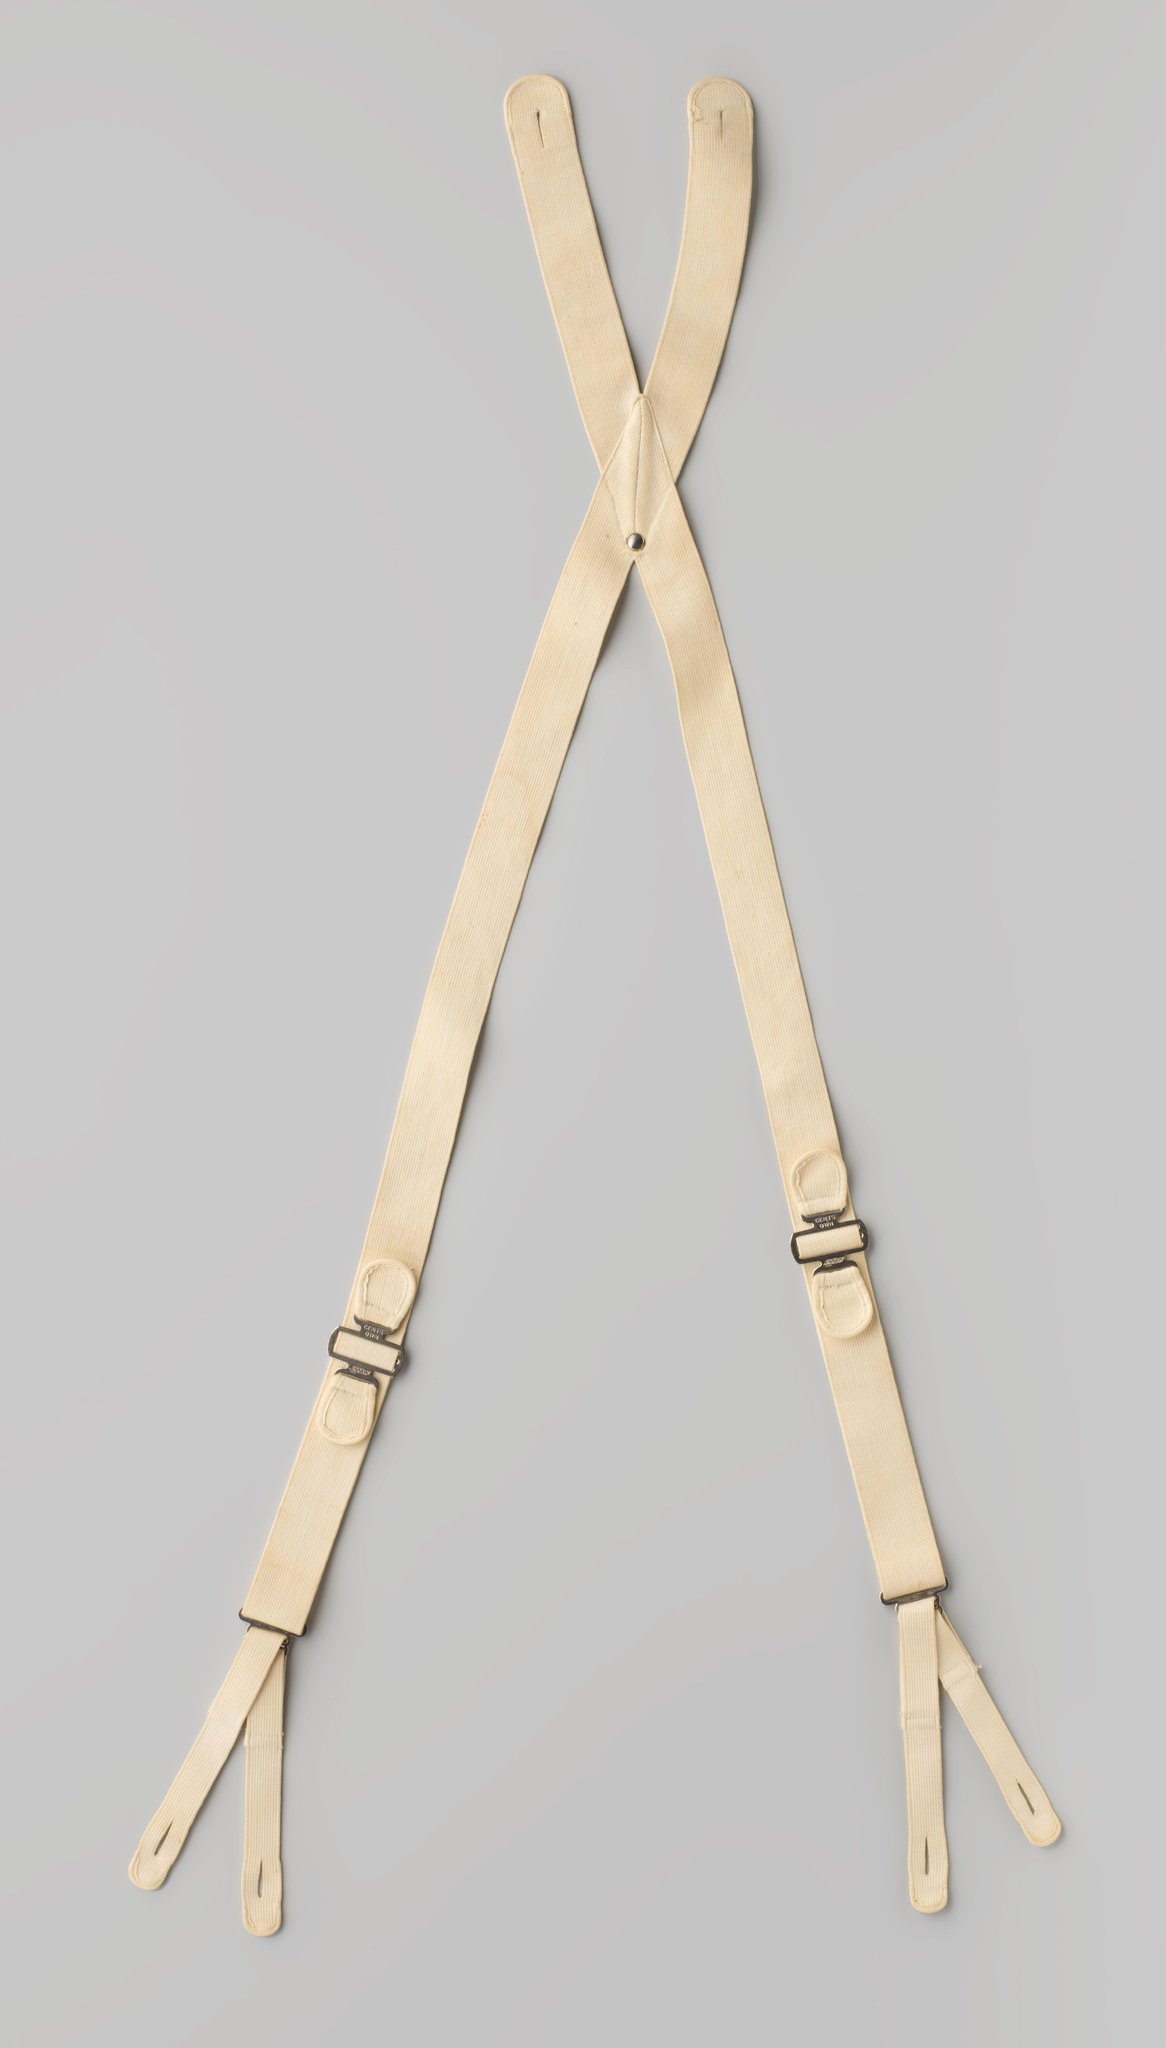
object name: suspender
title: Bretels van ambassadeur Allard Merens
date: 1945-1976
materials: iron, textile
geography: london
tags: the hague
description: Bretels behorend bij de diplomatieke ambtskleding van ambassadeur Allard Merens.